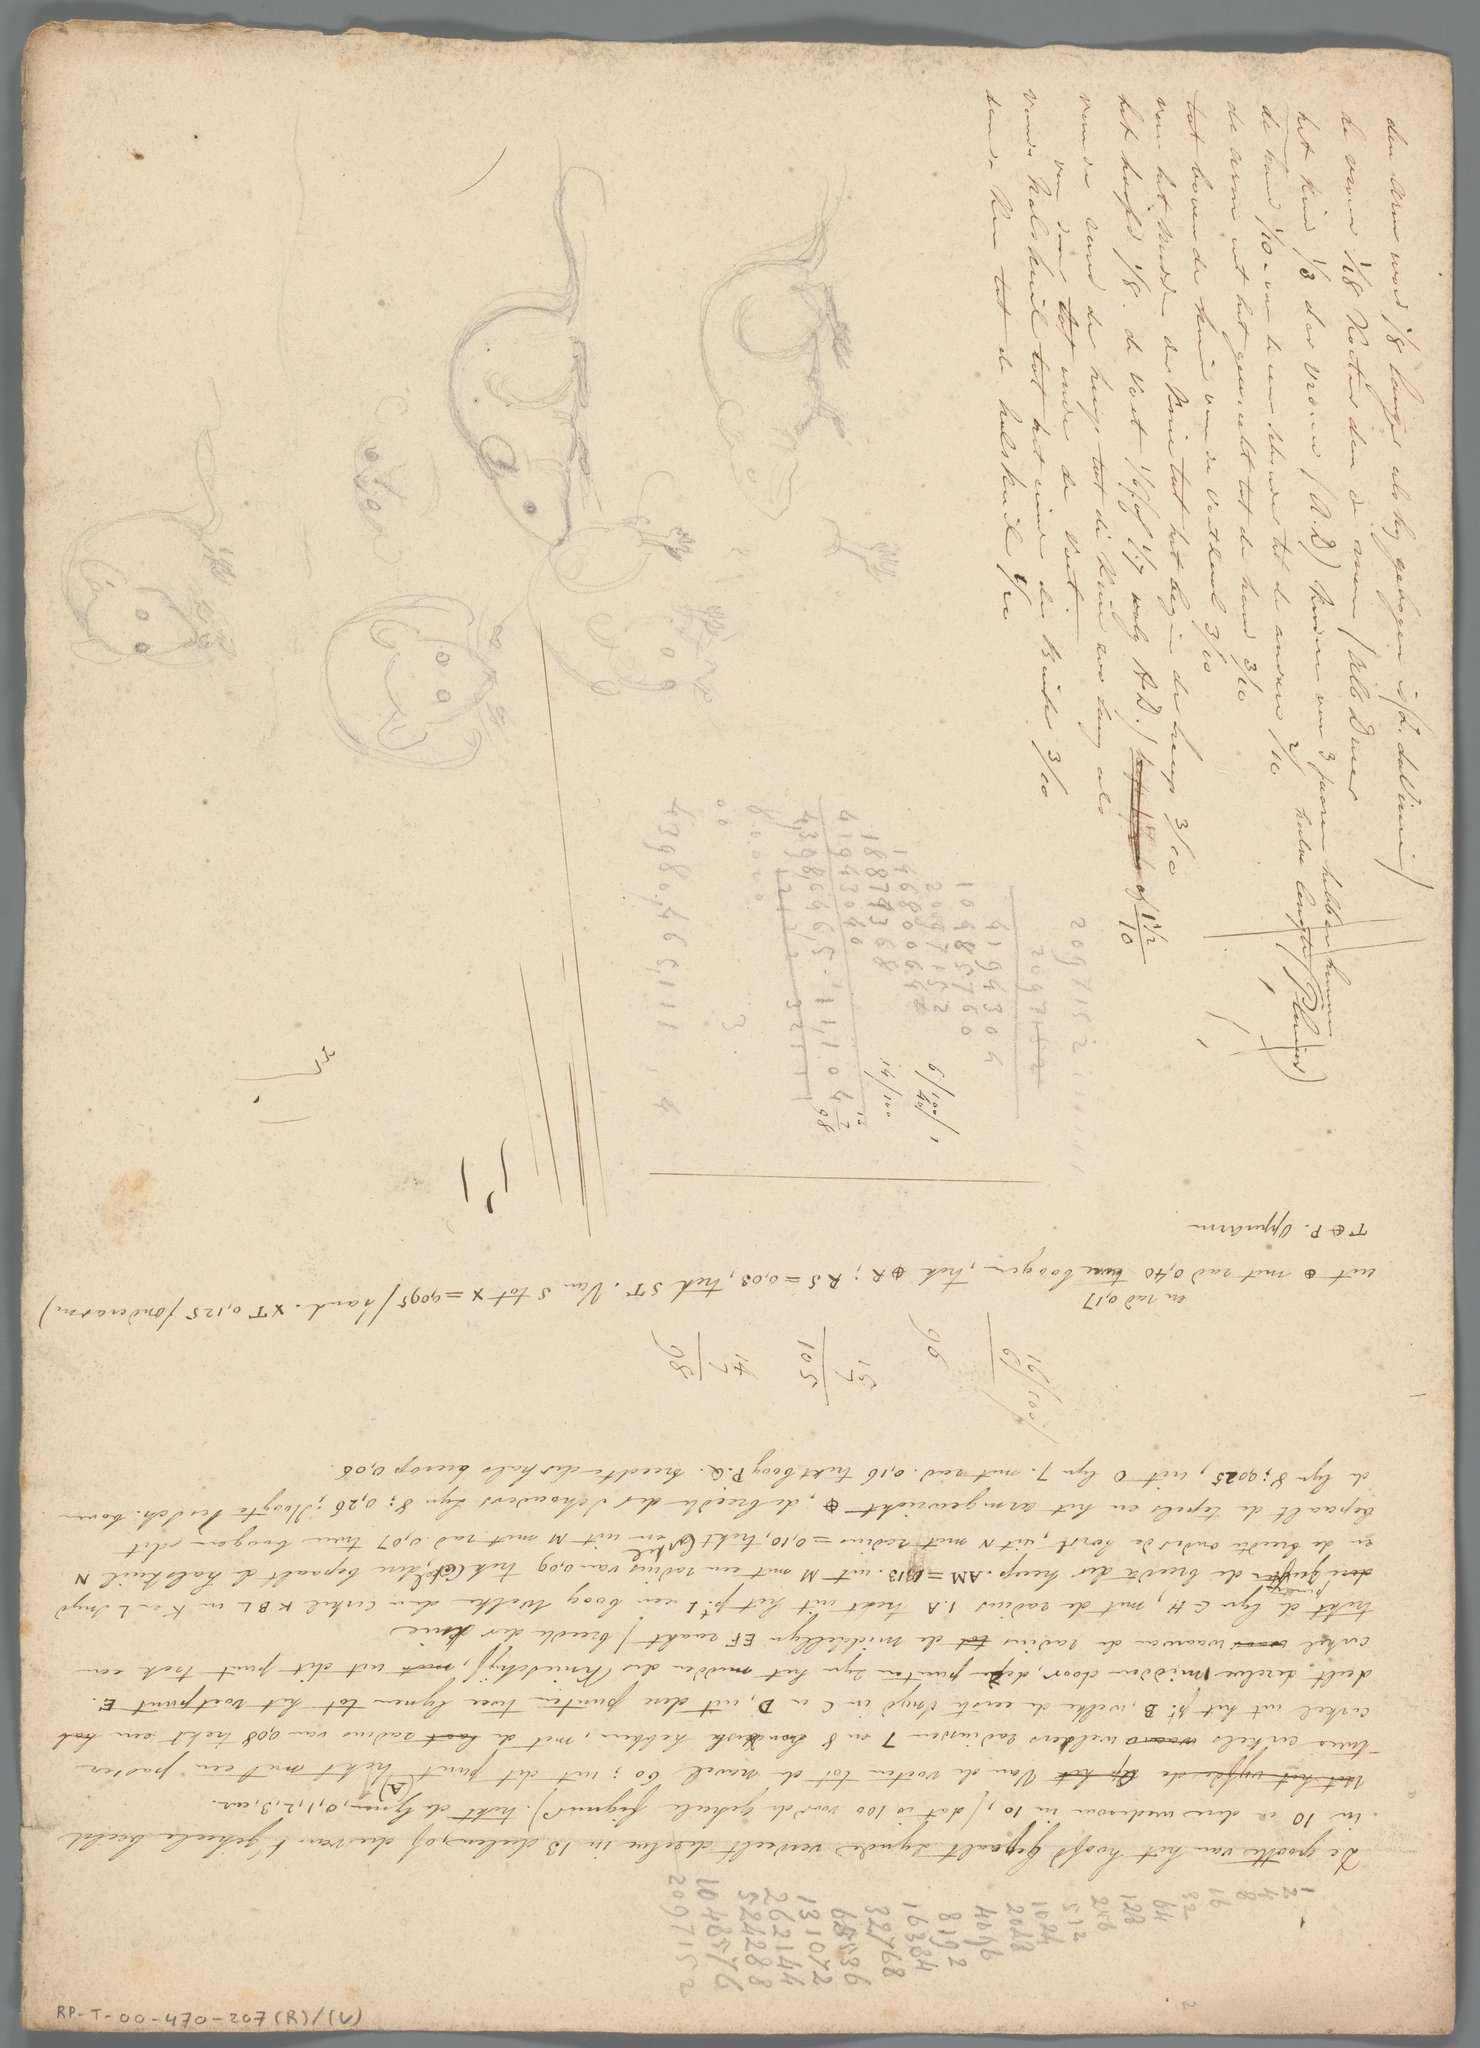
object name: drawing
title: Studies van een muis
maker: jacobus everhardus josephus van den berg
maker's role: draughtsman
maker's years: 1802-1861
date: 1812-1861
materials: ink, paper, pencil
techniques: pen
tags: rodents: mouse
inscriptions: inscription: ‘De grootte van het hoofd bepaalt zynde verdeelt dezelve in 13 deelen, (...)’